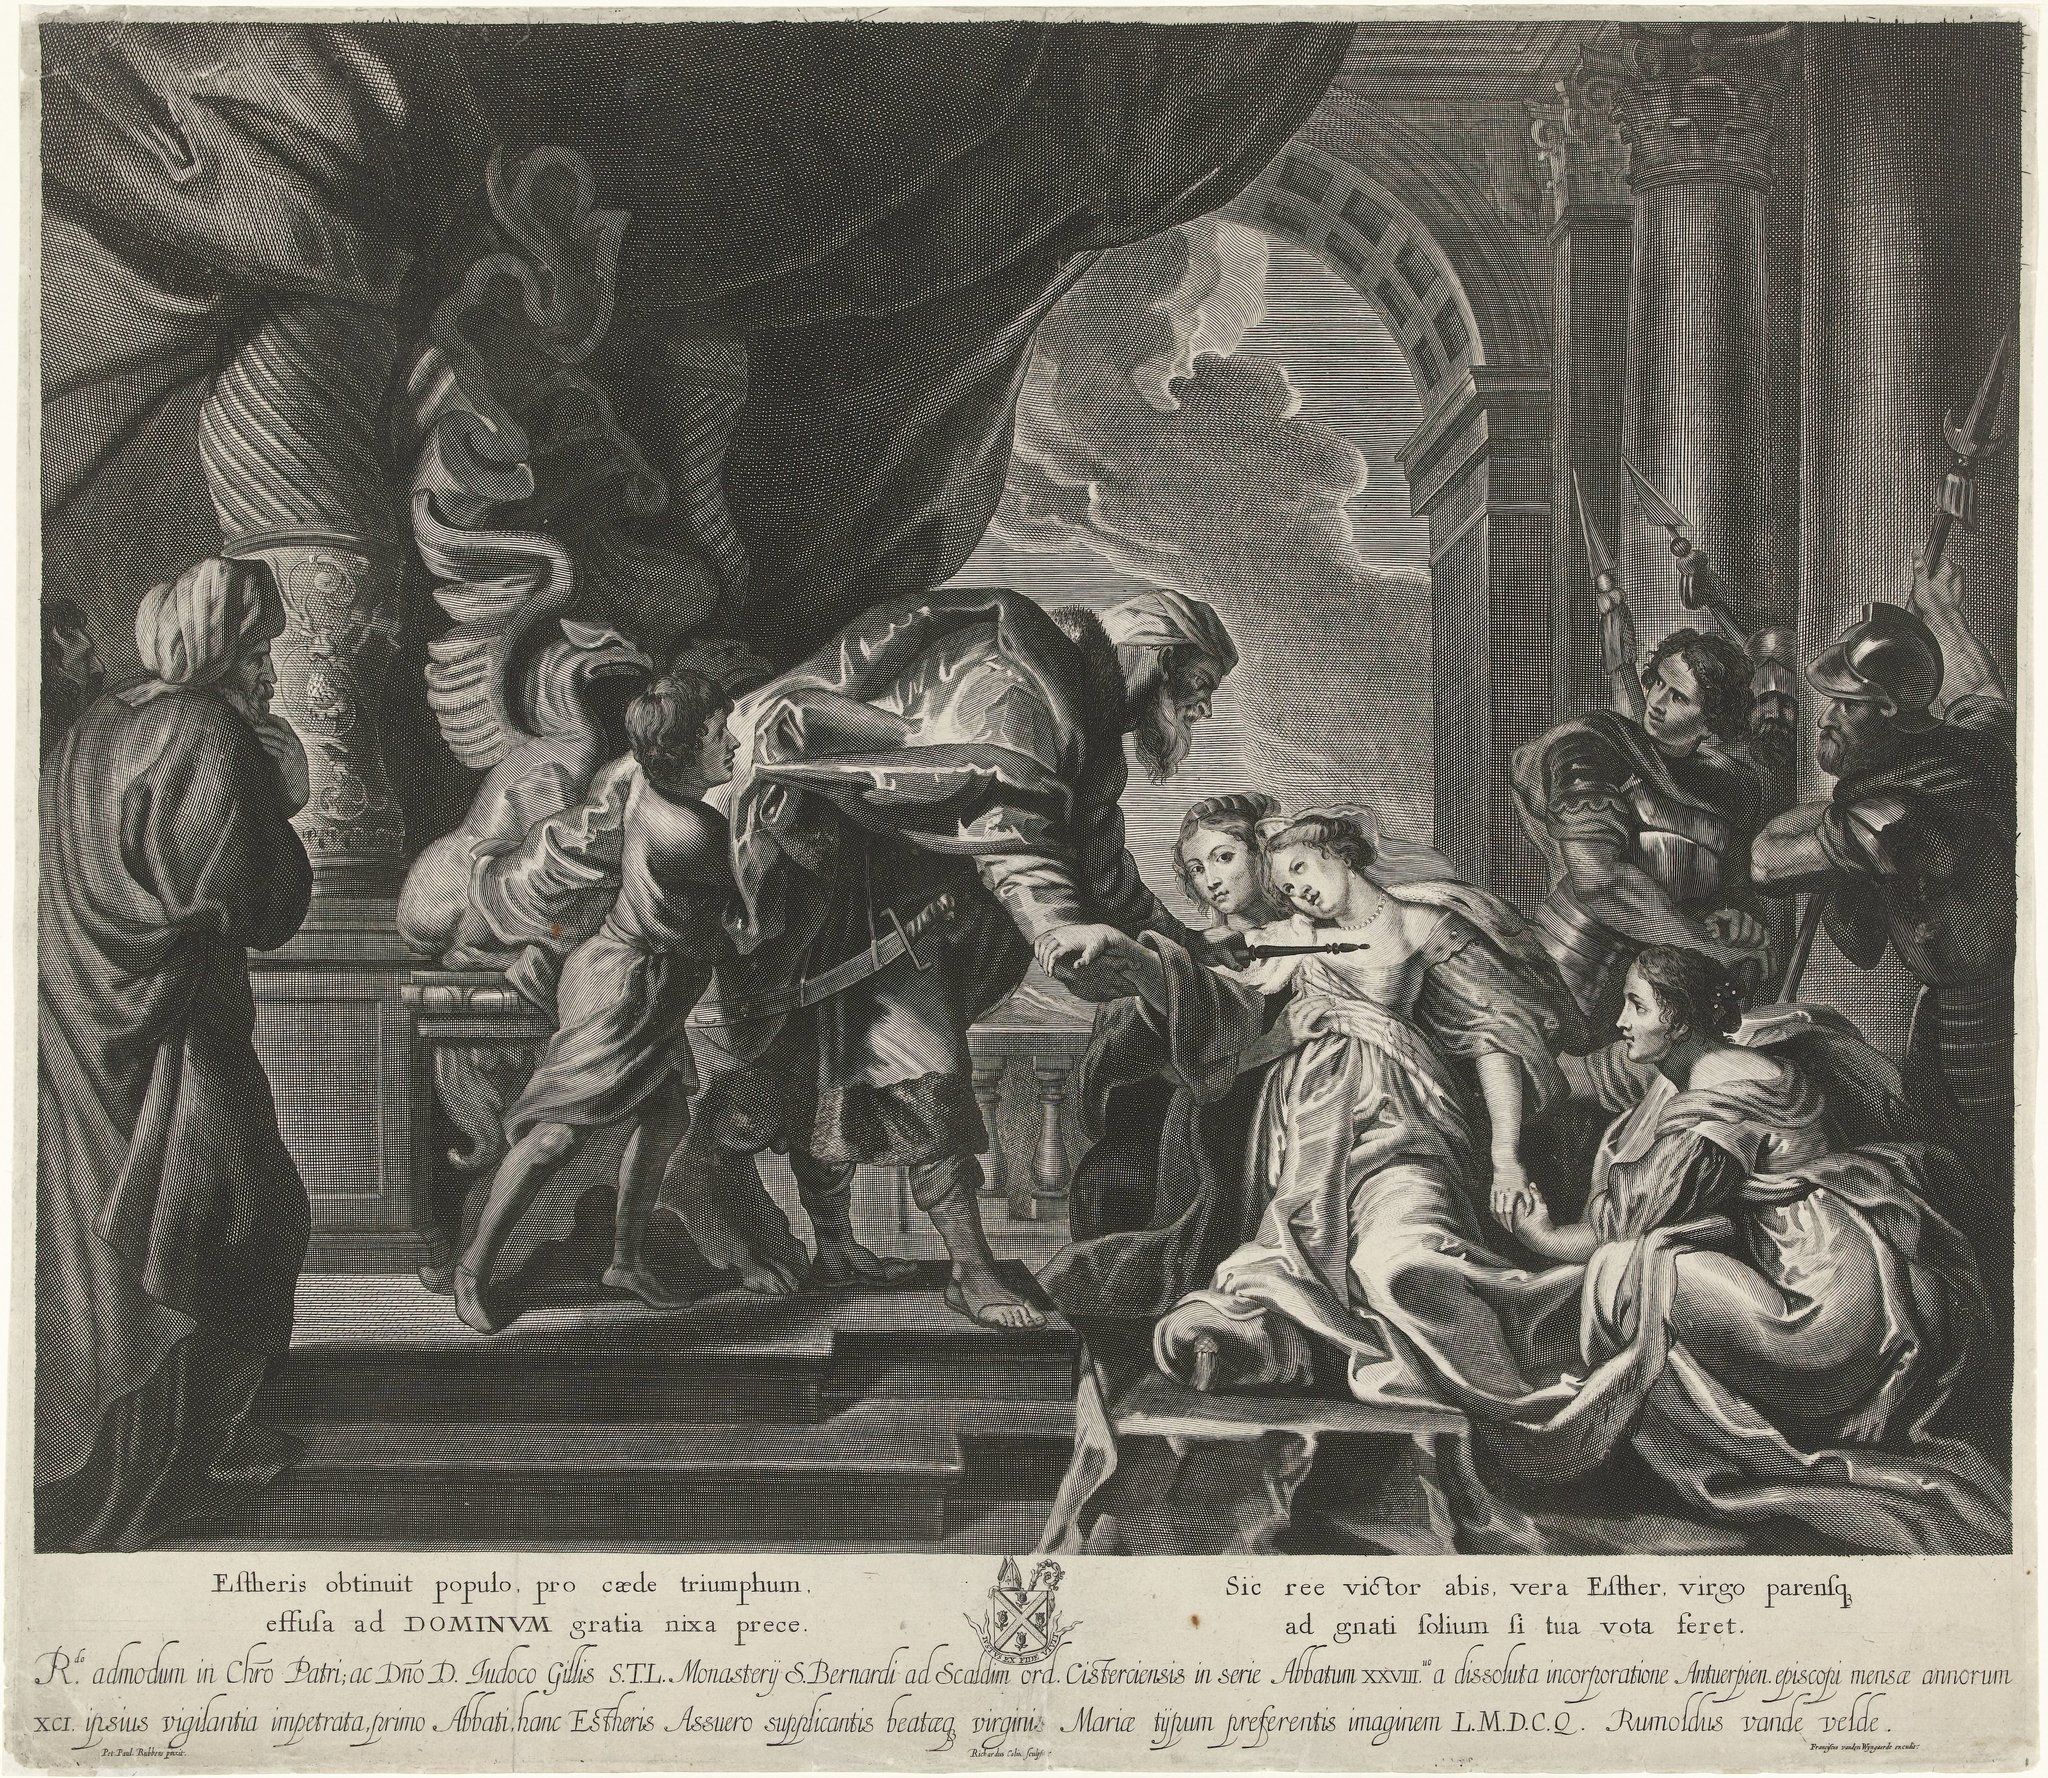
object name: print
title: Esther voor Ahasveros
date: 1650-1679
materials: paper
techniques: engraving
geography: antwerp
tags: esther before ahasuerus (esther 5:1-4)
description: Esther zakt in elkaar voor de troon van koning Ahasveros. Ze moet door twee dienaressen gesteund worden. Koning Ahasveros reikt haar de hand. Onder het portret een Latijns vers en een bisschoppelijk wapen.